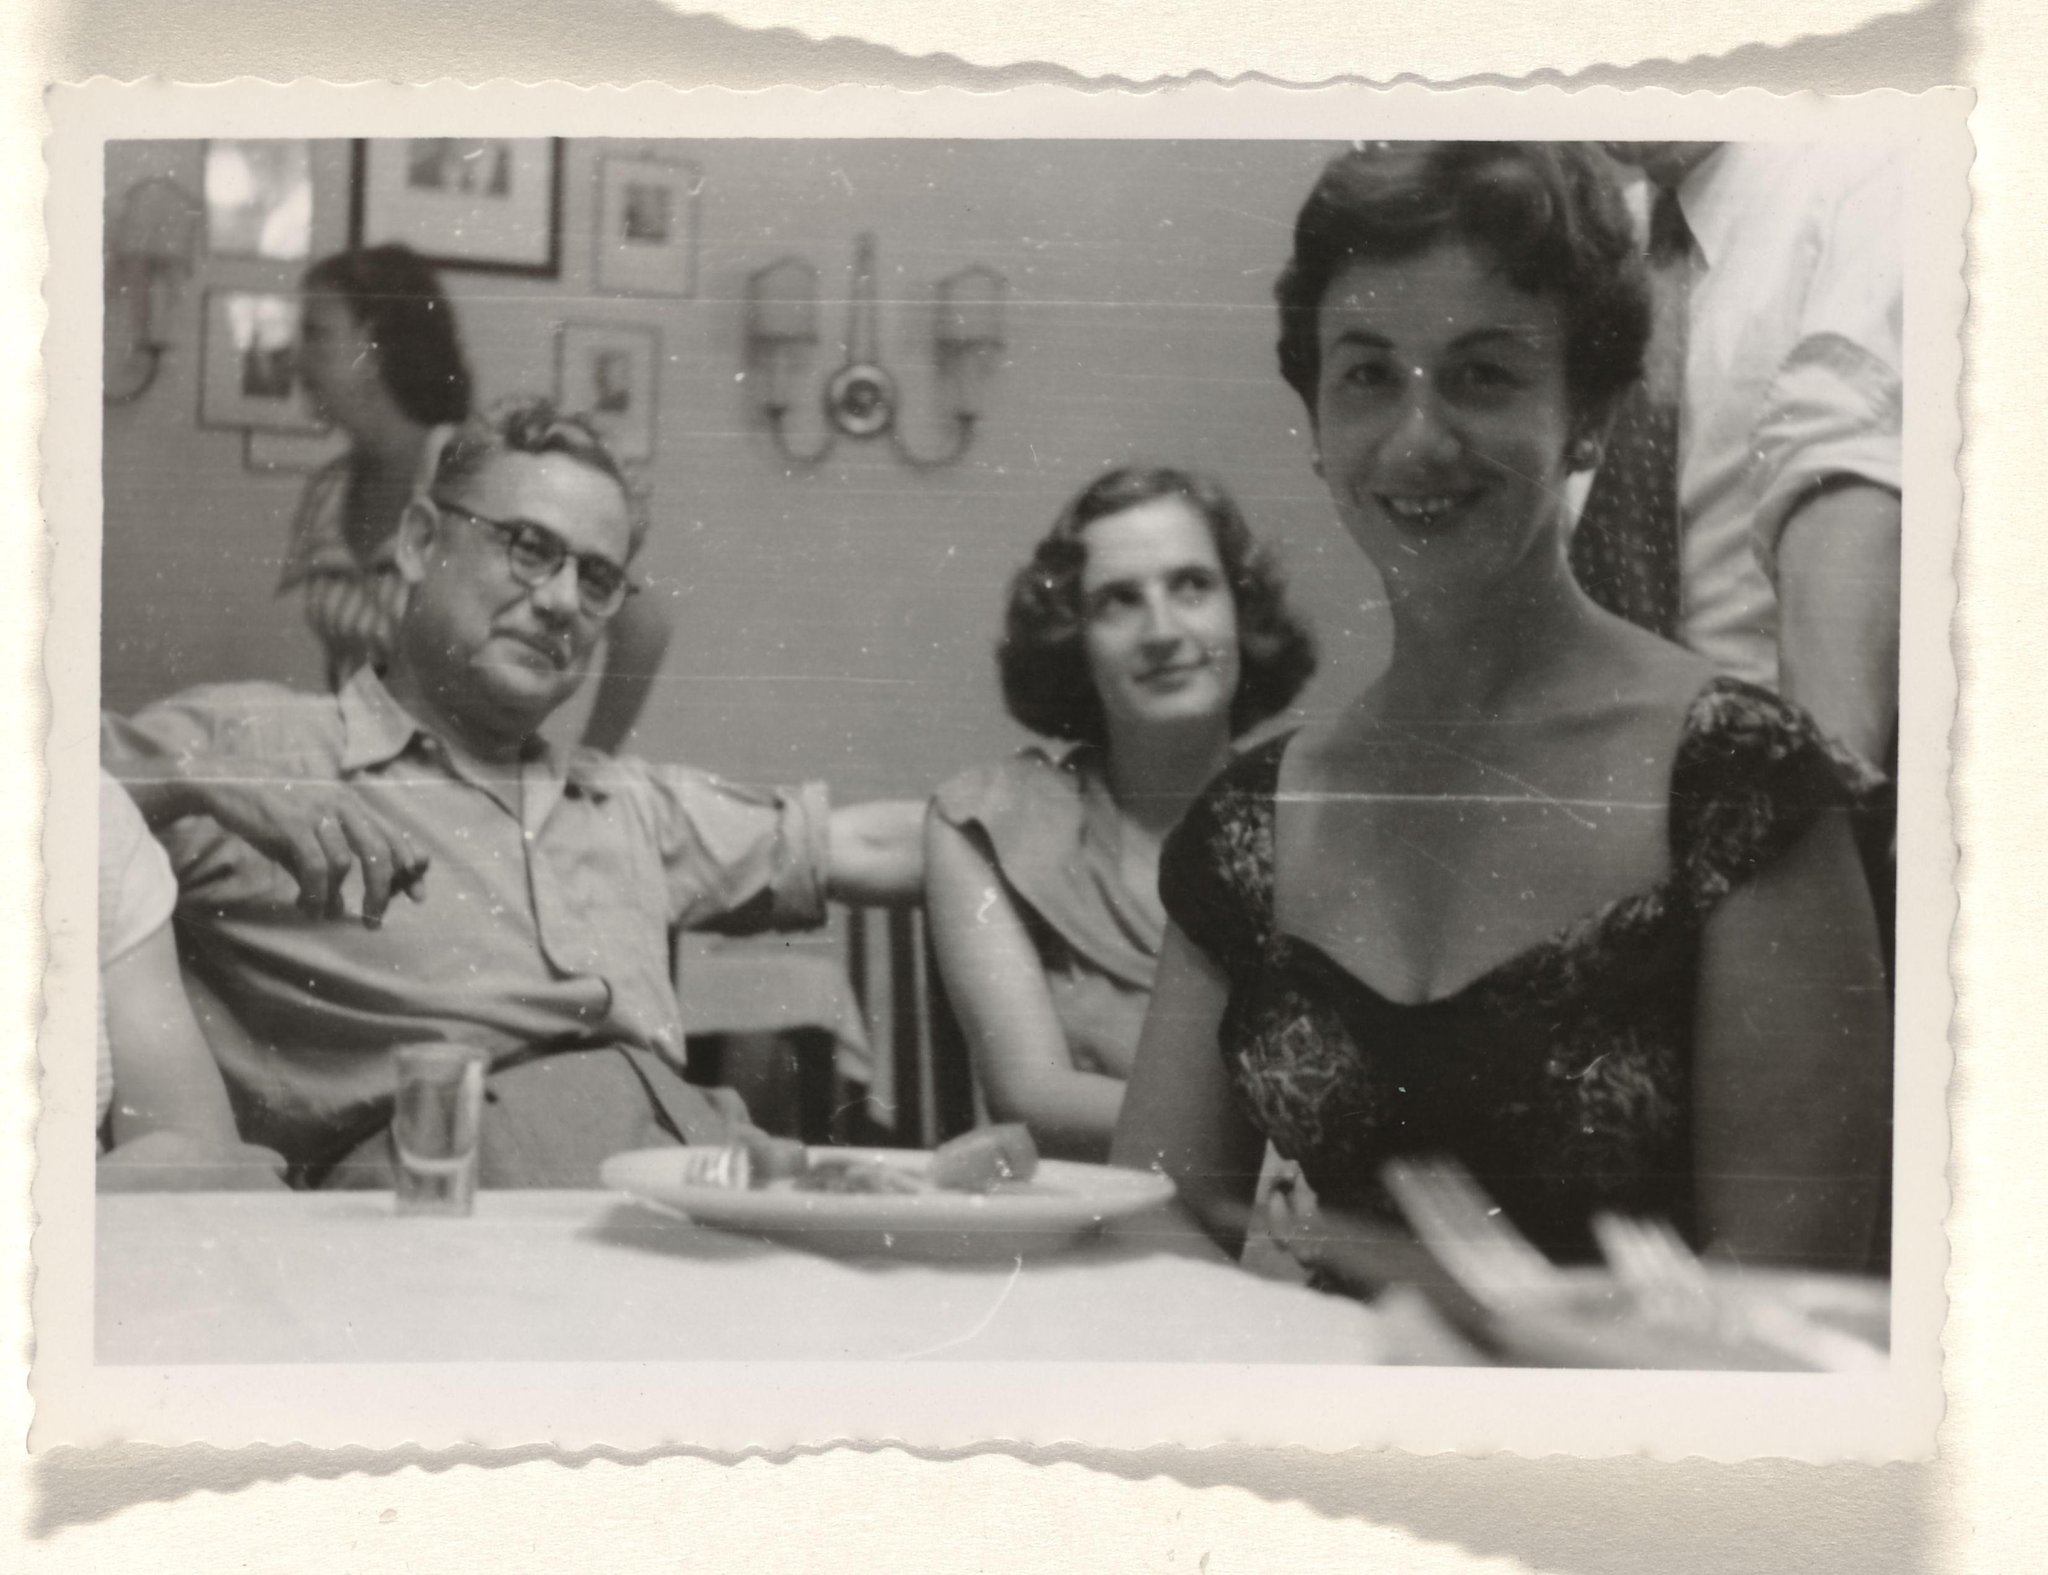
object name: photograph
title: Isabel Wachenheimer met een onbekende man en een onbekende vrouw tijdens een banket voor de armen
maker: Anonymous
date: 1946-1963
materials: photographic support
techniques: gelatin silver print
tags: leiden, isabel wachenheimer-elon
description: Isabel Wachenheimer (midden) met een onbekende man en een onbekende vrouw tijdens een banket.